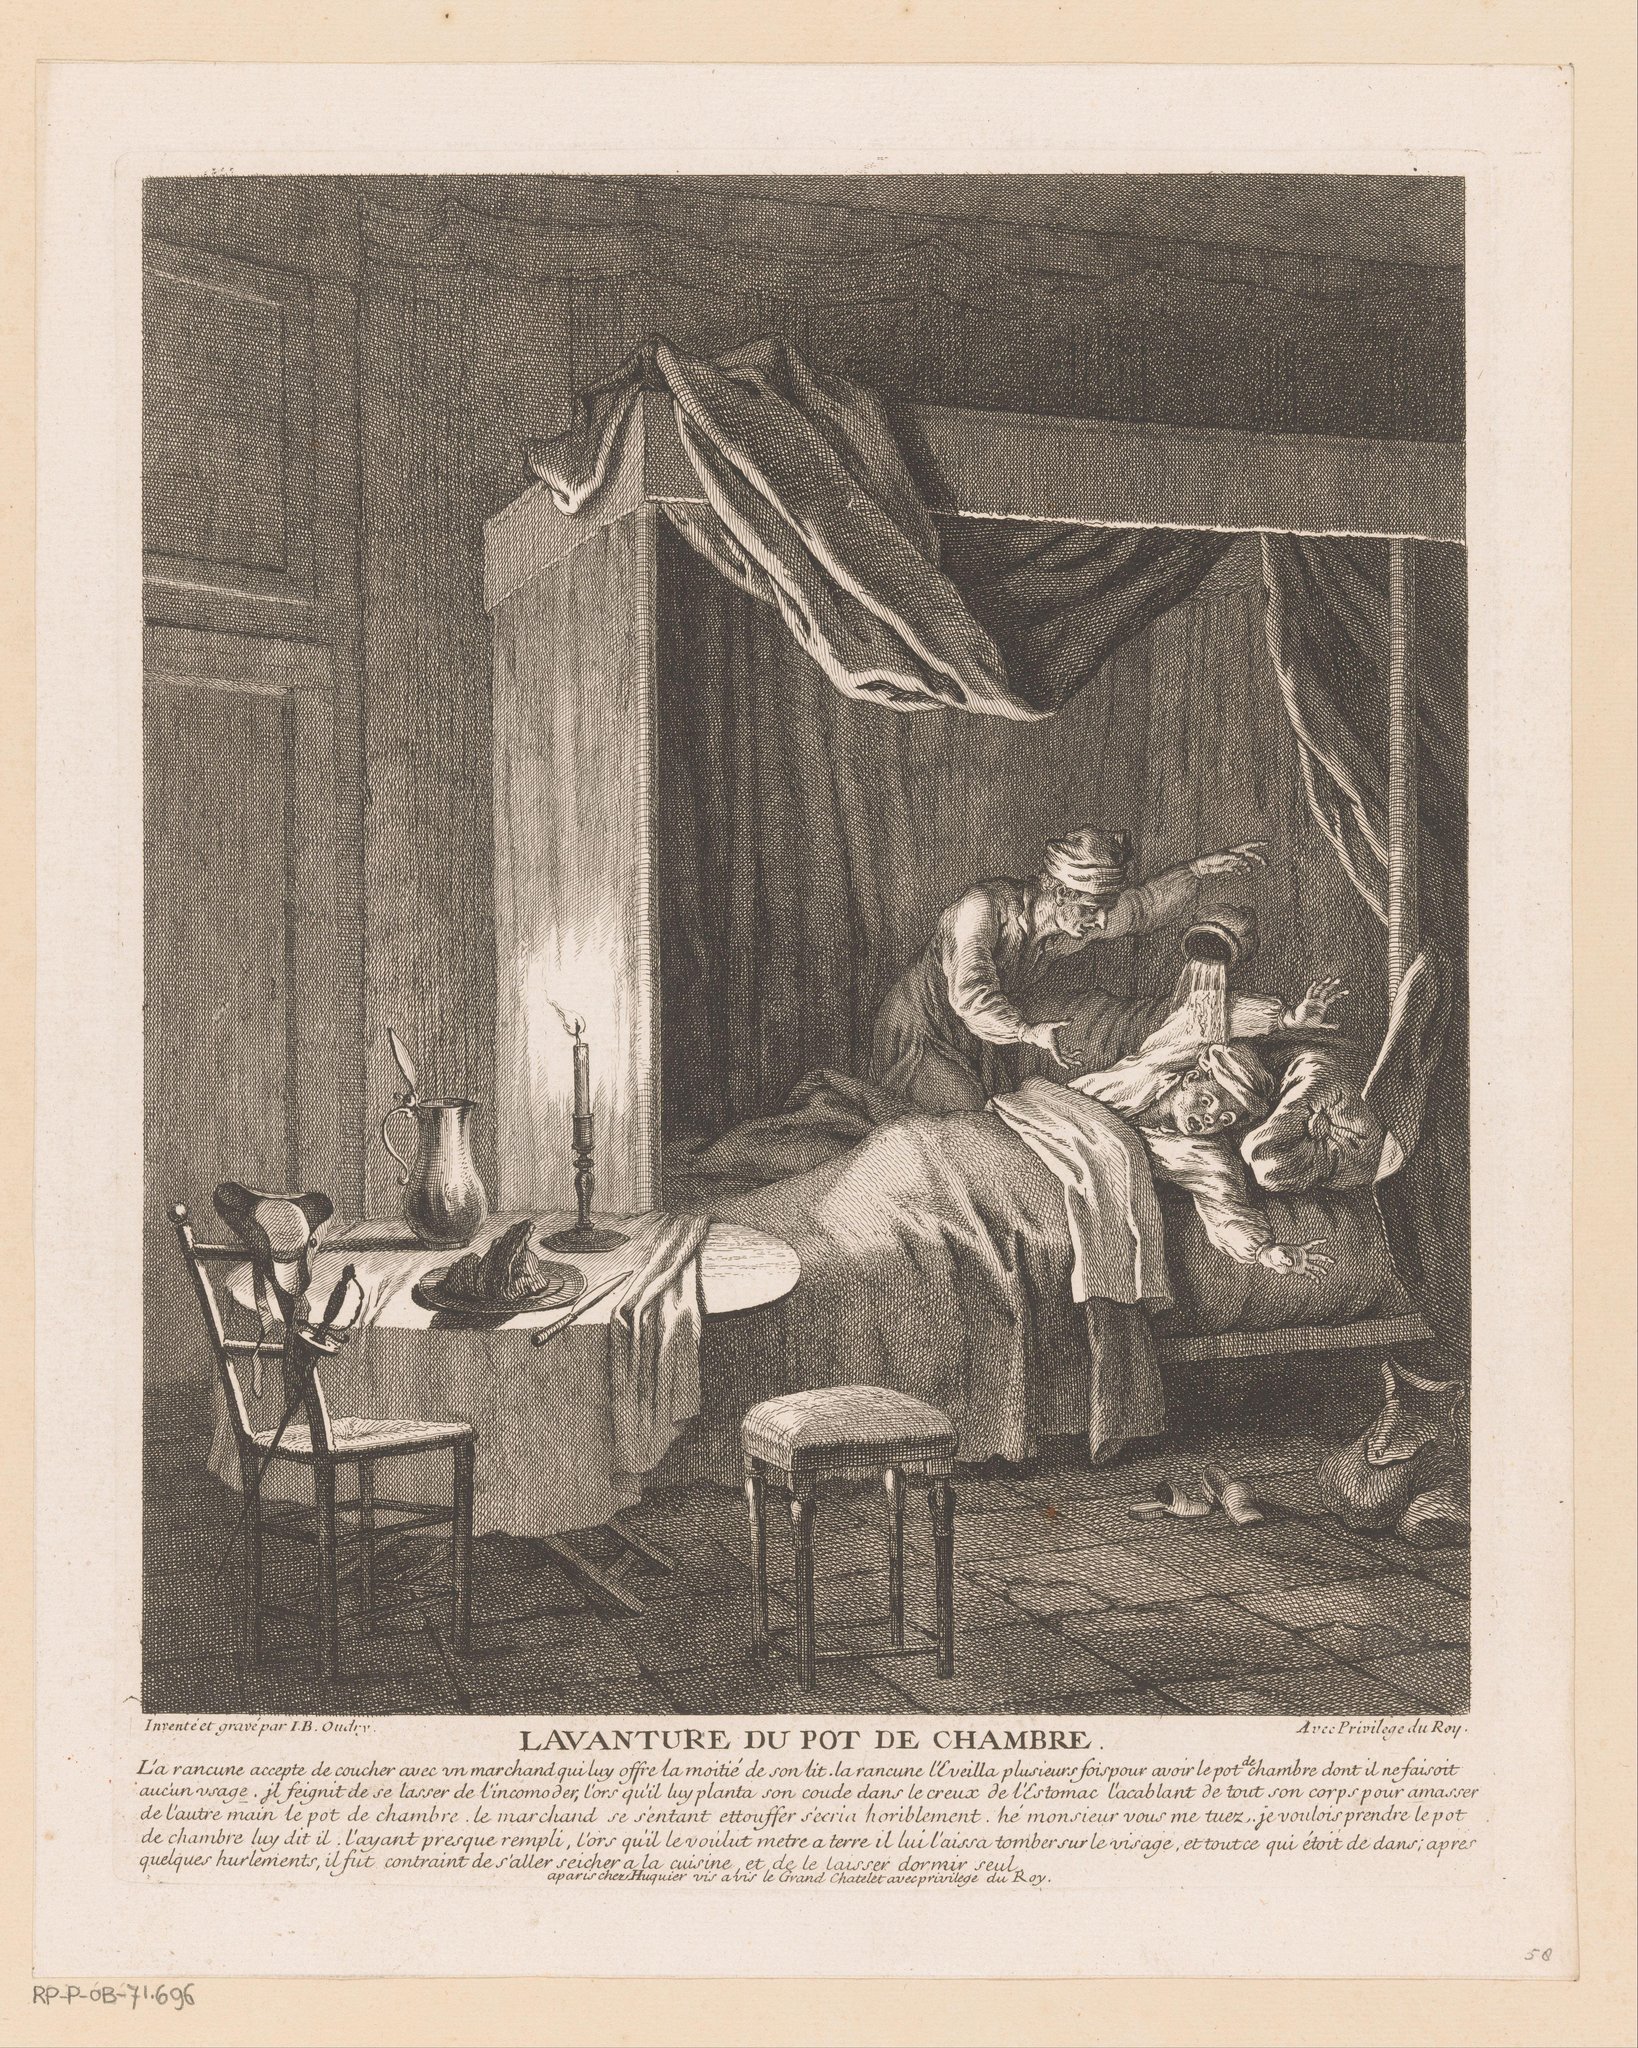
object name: print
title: Lavanture du pot de chambre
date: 1696-1755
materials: paper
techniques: engraving, etching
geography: france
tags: (scarron, roman comique) specific works of literature (with author, title), chamber-pot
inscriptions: collector's mark: Lugt 240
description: Prent maakt deel uit van een ongenummerde serie van 21 prenten.